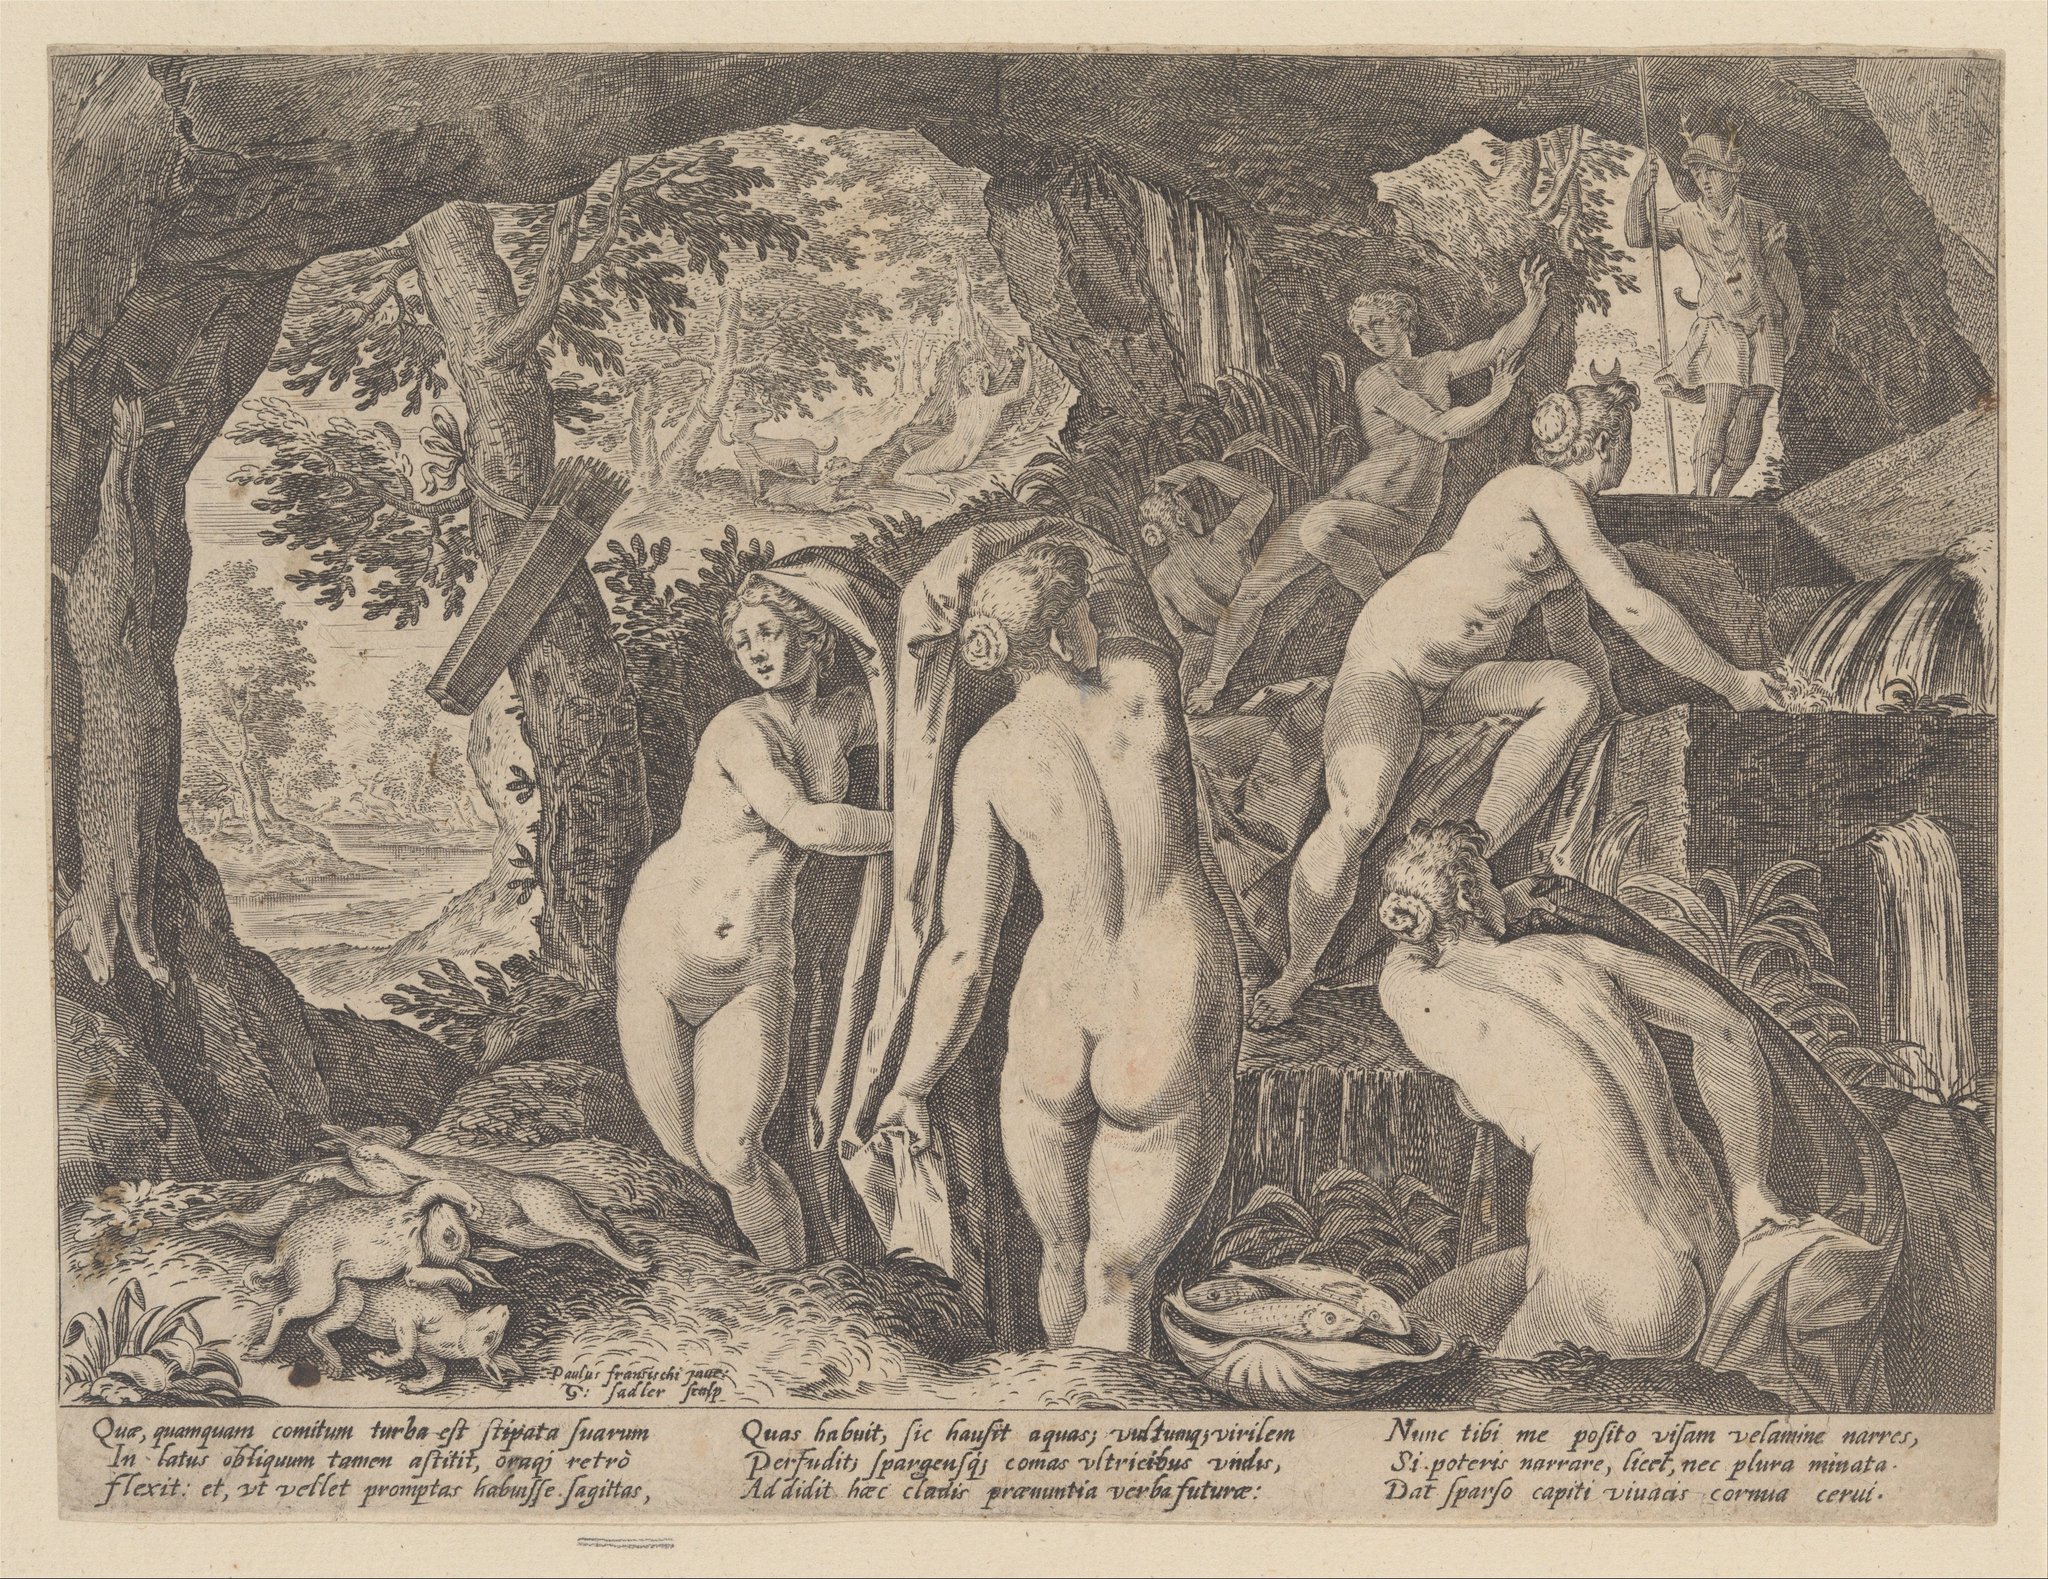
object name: print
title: Diana Surprised by Actaeon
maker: aegidius sadeler (ii)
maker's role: artist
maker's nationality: flemish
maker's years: 1568-1629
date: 1586-1629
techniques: engraving, etching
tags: animals,female nudes,actaeon,diana